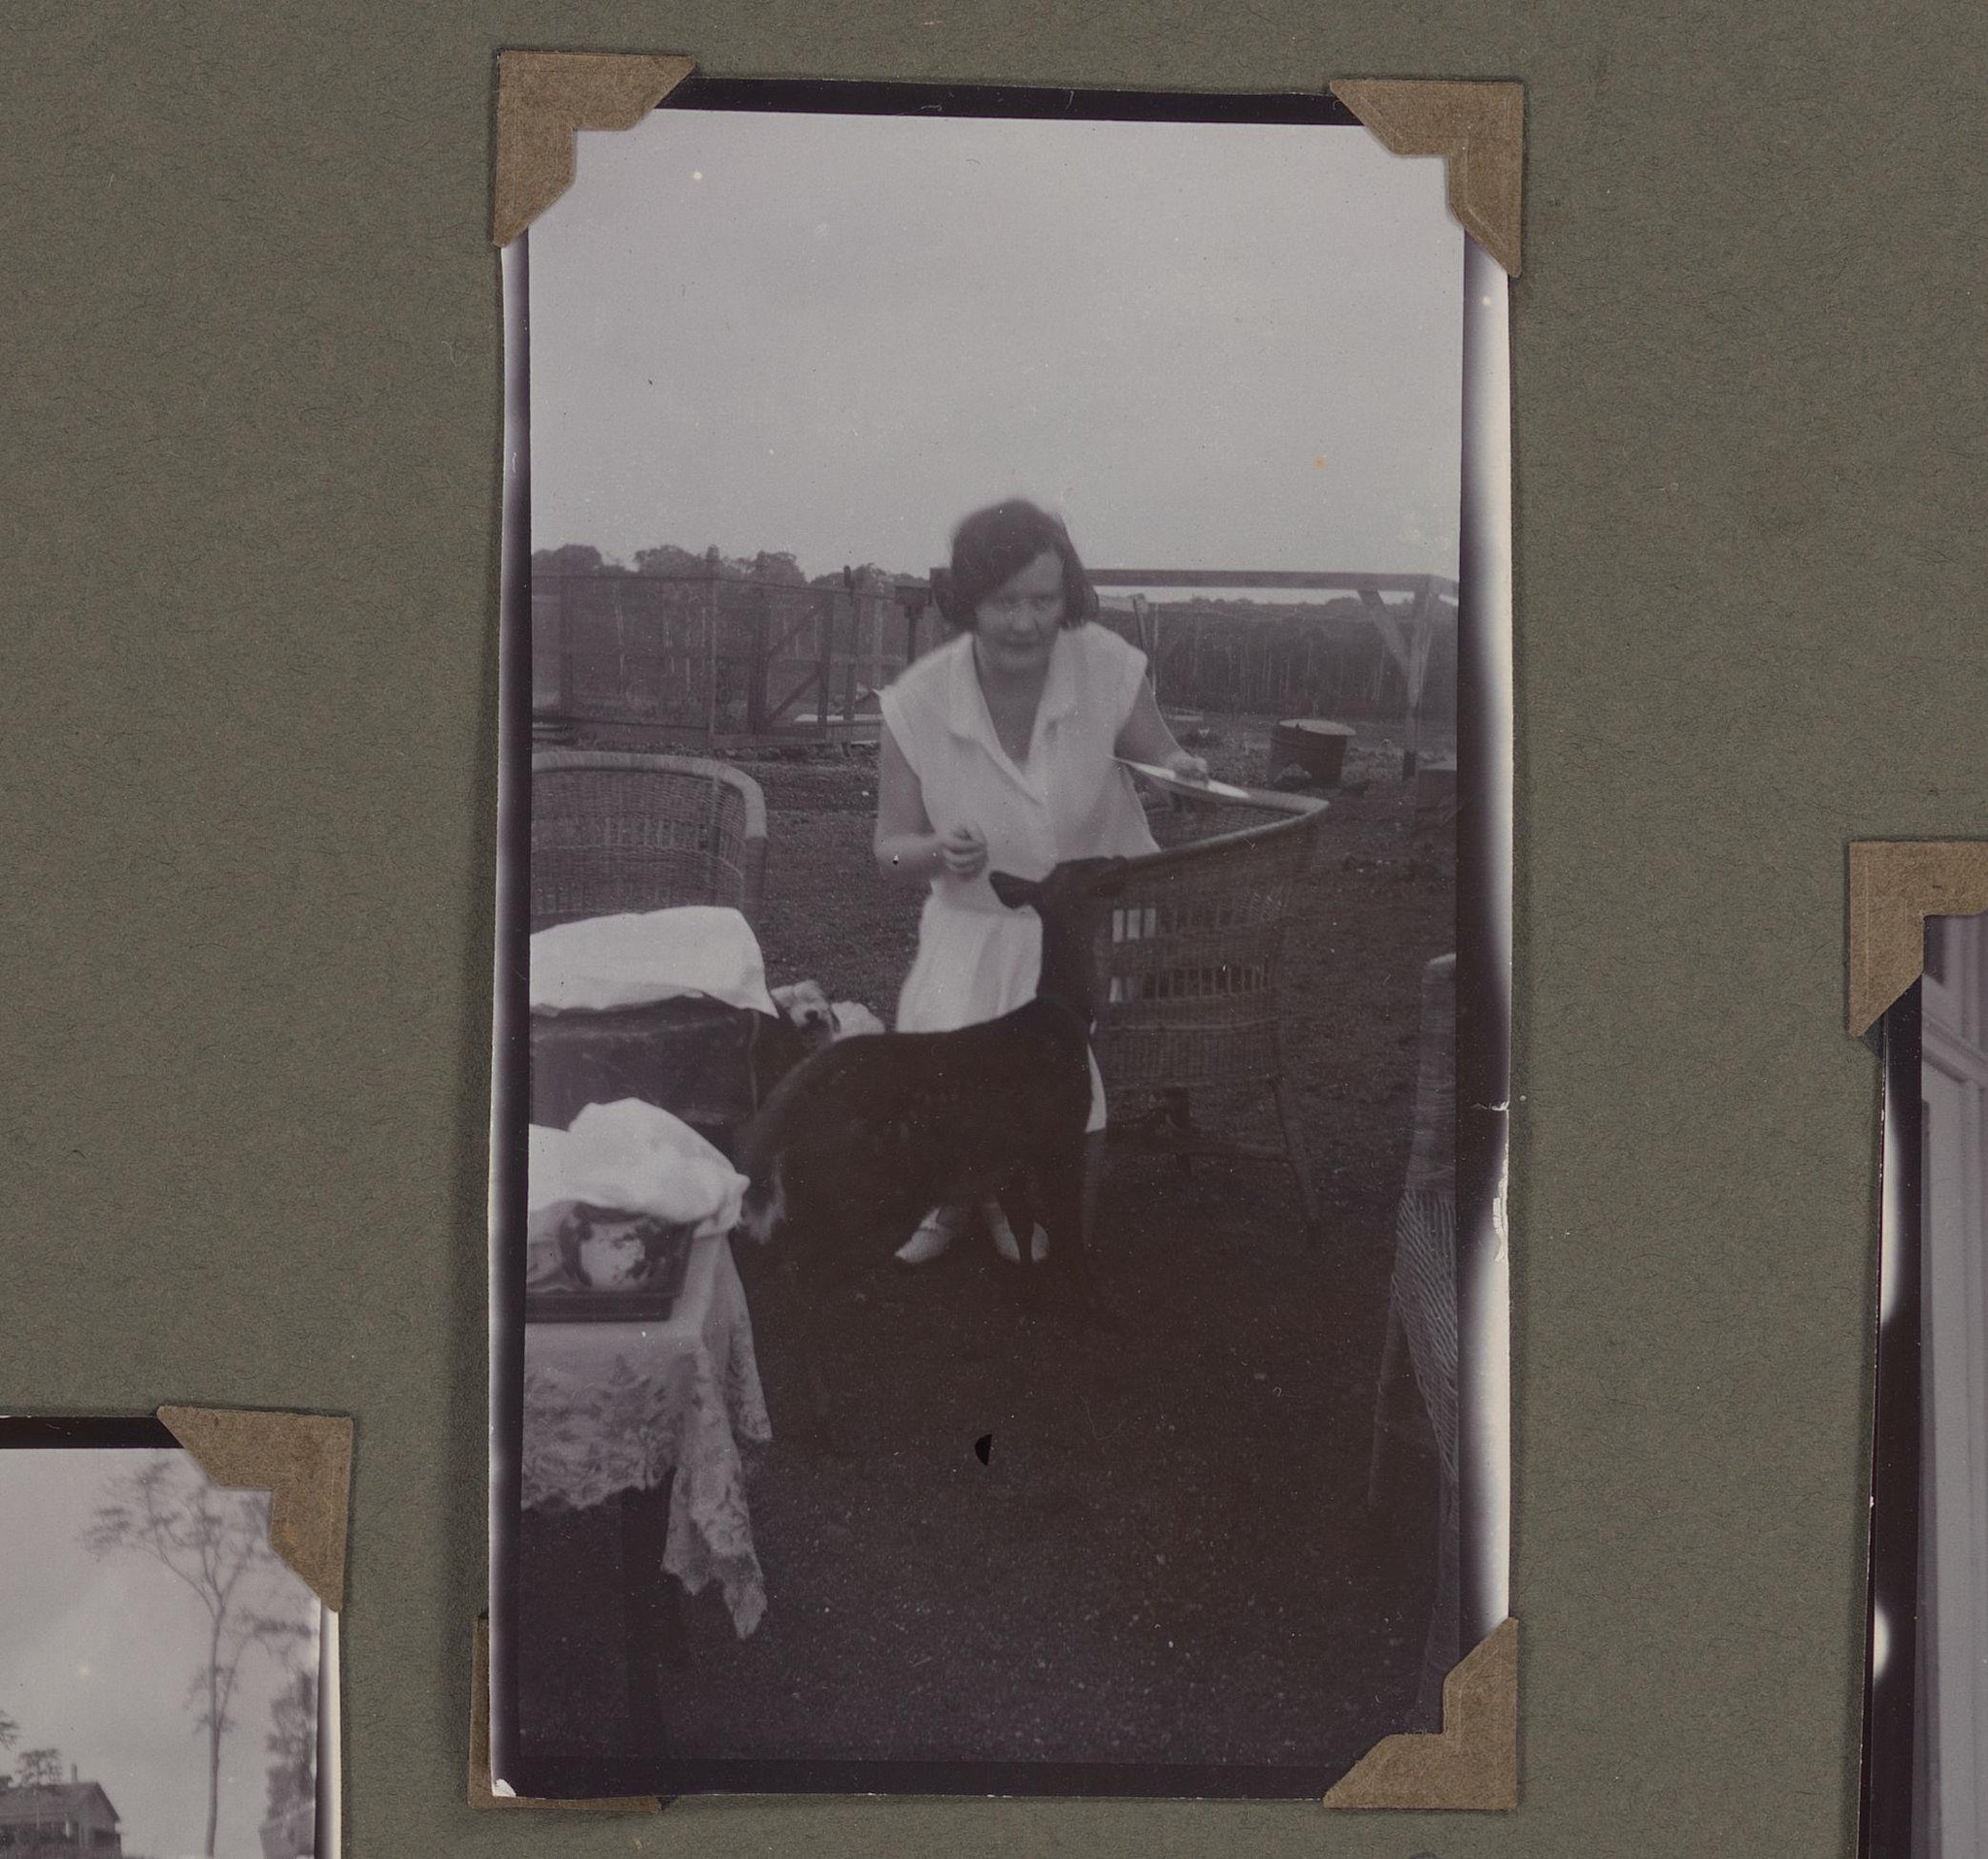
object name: photograph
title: Familiefoto van het gezin Jetten te Moengo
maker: Anonymous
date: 1925-1927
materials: photographic support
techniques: photography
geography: suriname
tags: jetten, familie, moengo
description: Familiefoto van het gezin Jetten te Moengo. Foto op een bladzijde van een los albumblad. Onderdeel van het ensemble met foto's van de familie van ingenieur Jetten in de mijnbouwstad Moengo in Suriname.